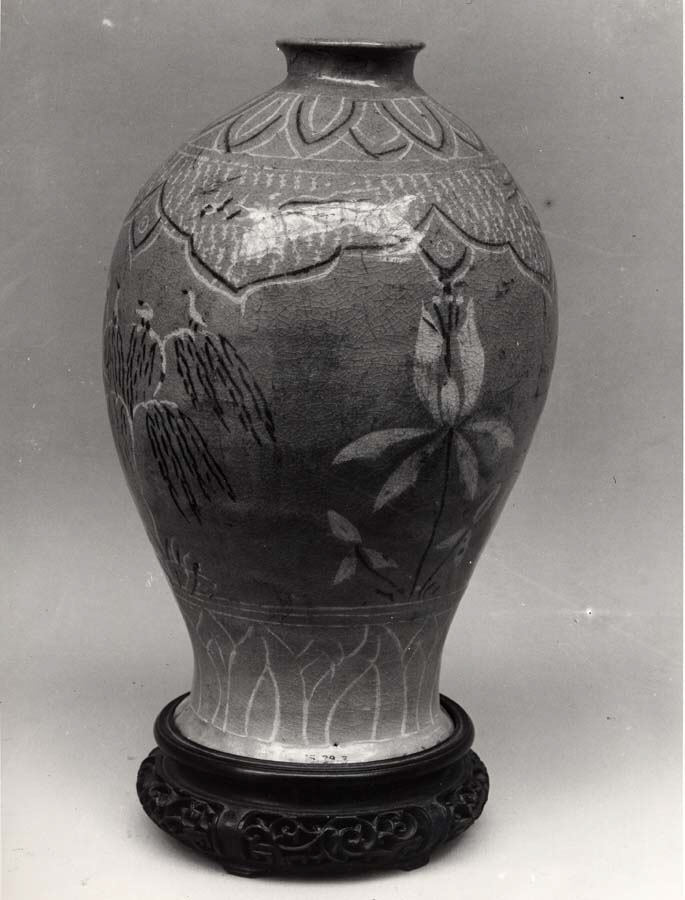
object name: vase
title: Vase with Inlaid Designs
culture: korean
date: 1901-1933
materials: ceramic glaze, glaze, stoneware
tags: flowers